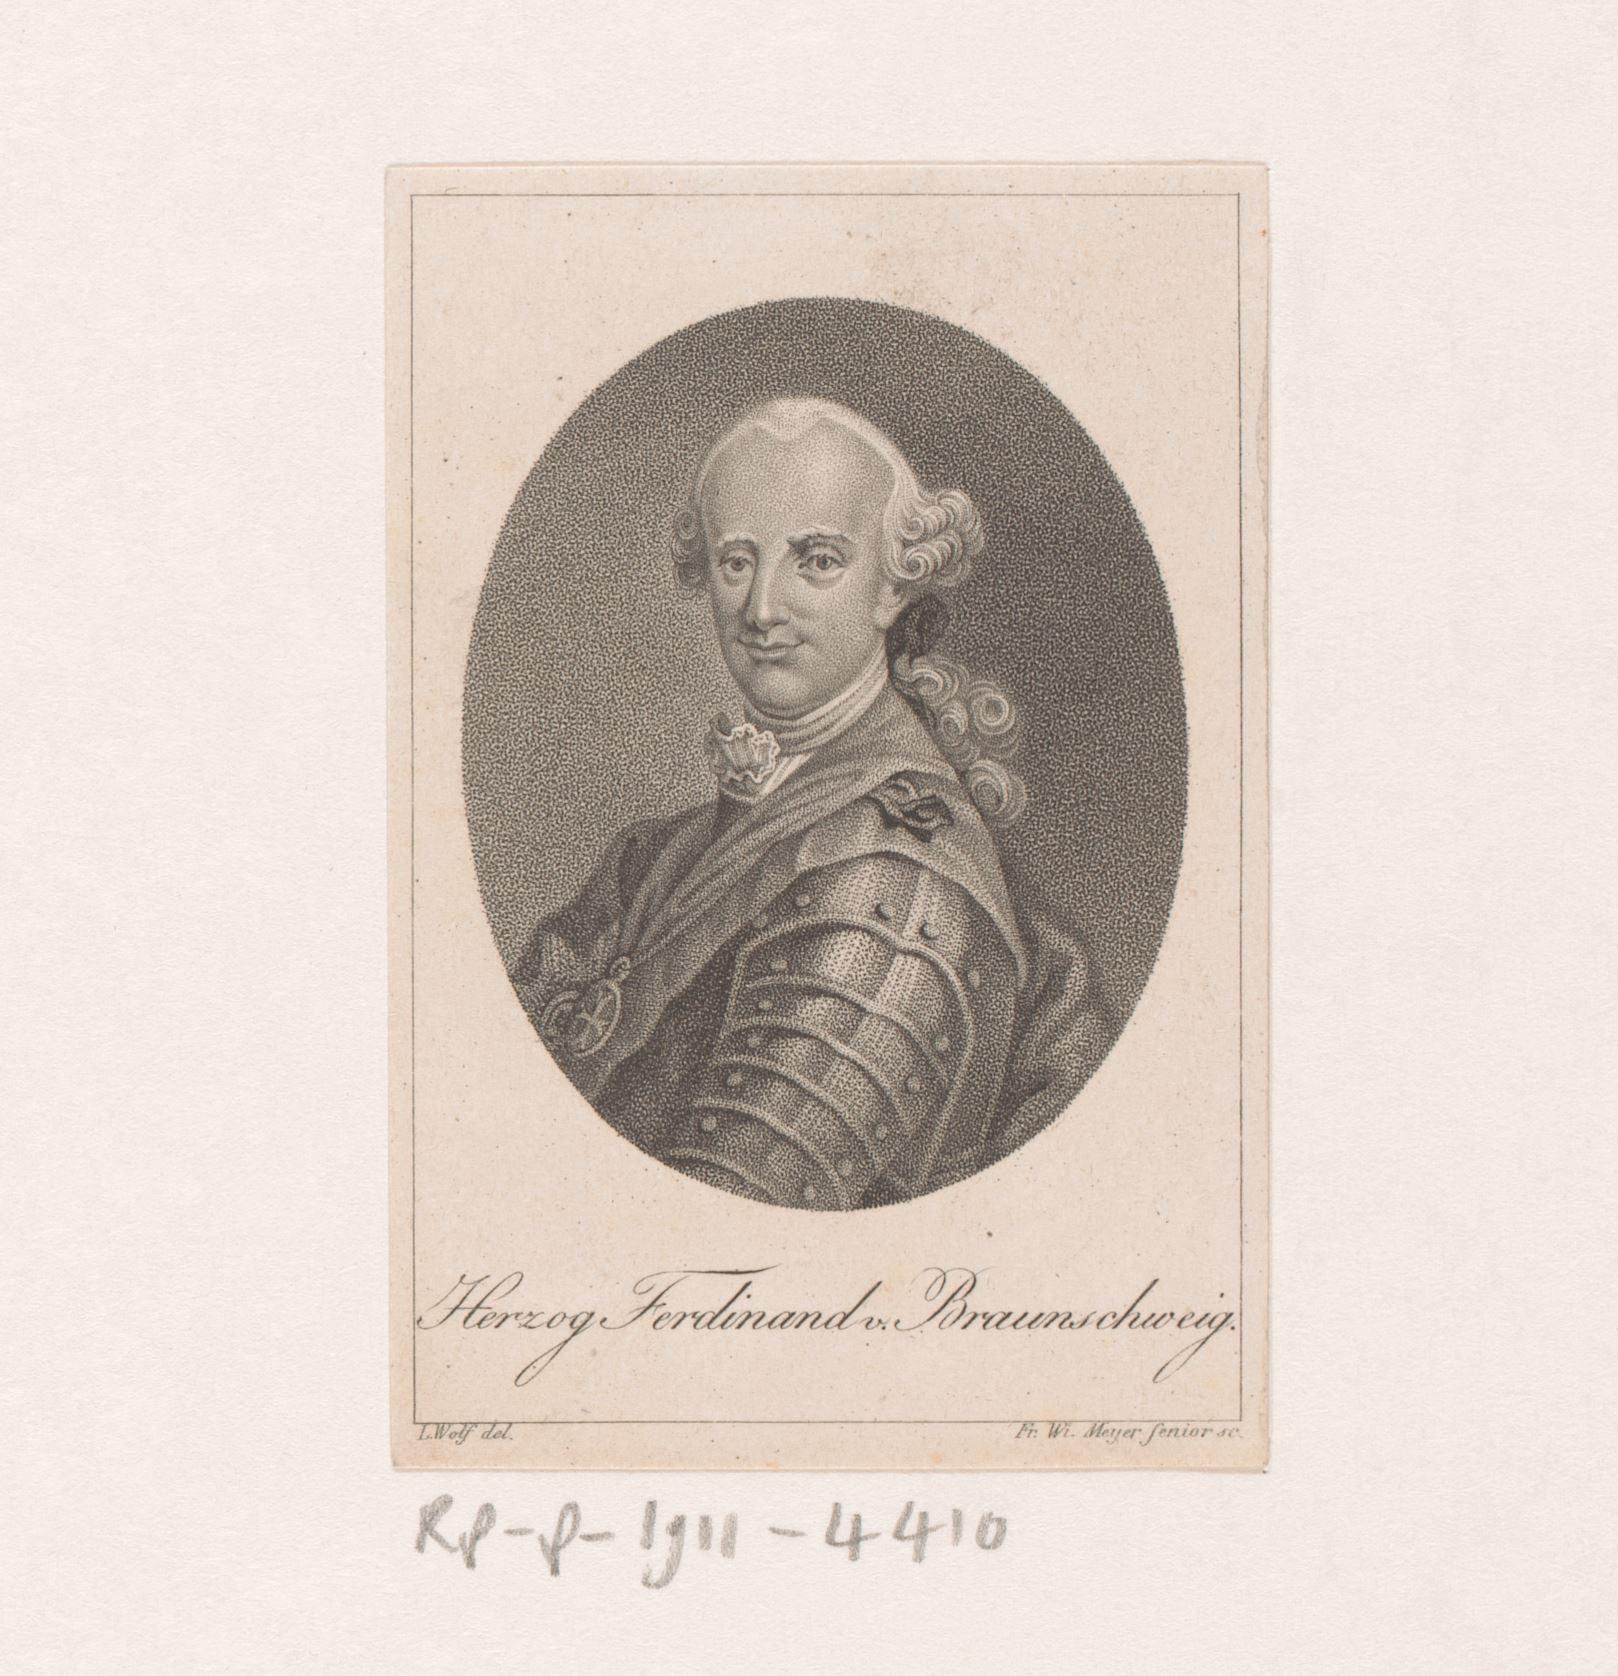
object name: print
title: Portret van Ferdinand hertog van Brunswijk-Lüneburg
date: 1780-1880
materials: paper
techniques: engraving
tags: historical persons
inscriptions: collector's mark: Lugt 2228